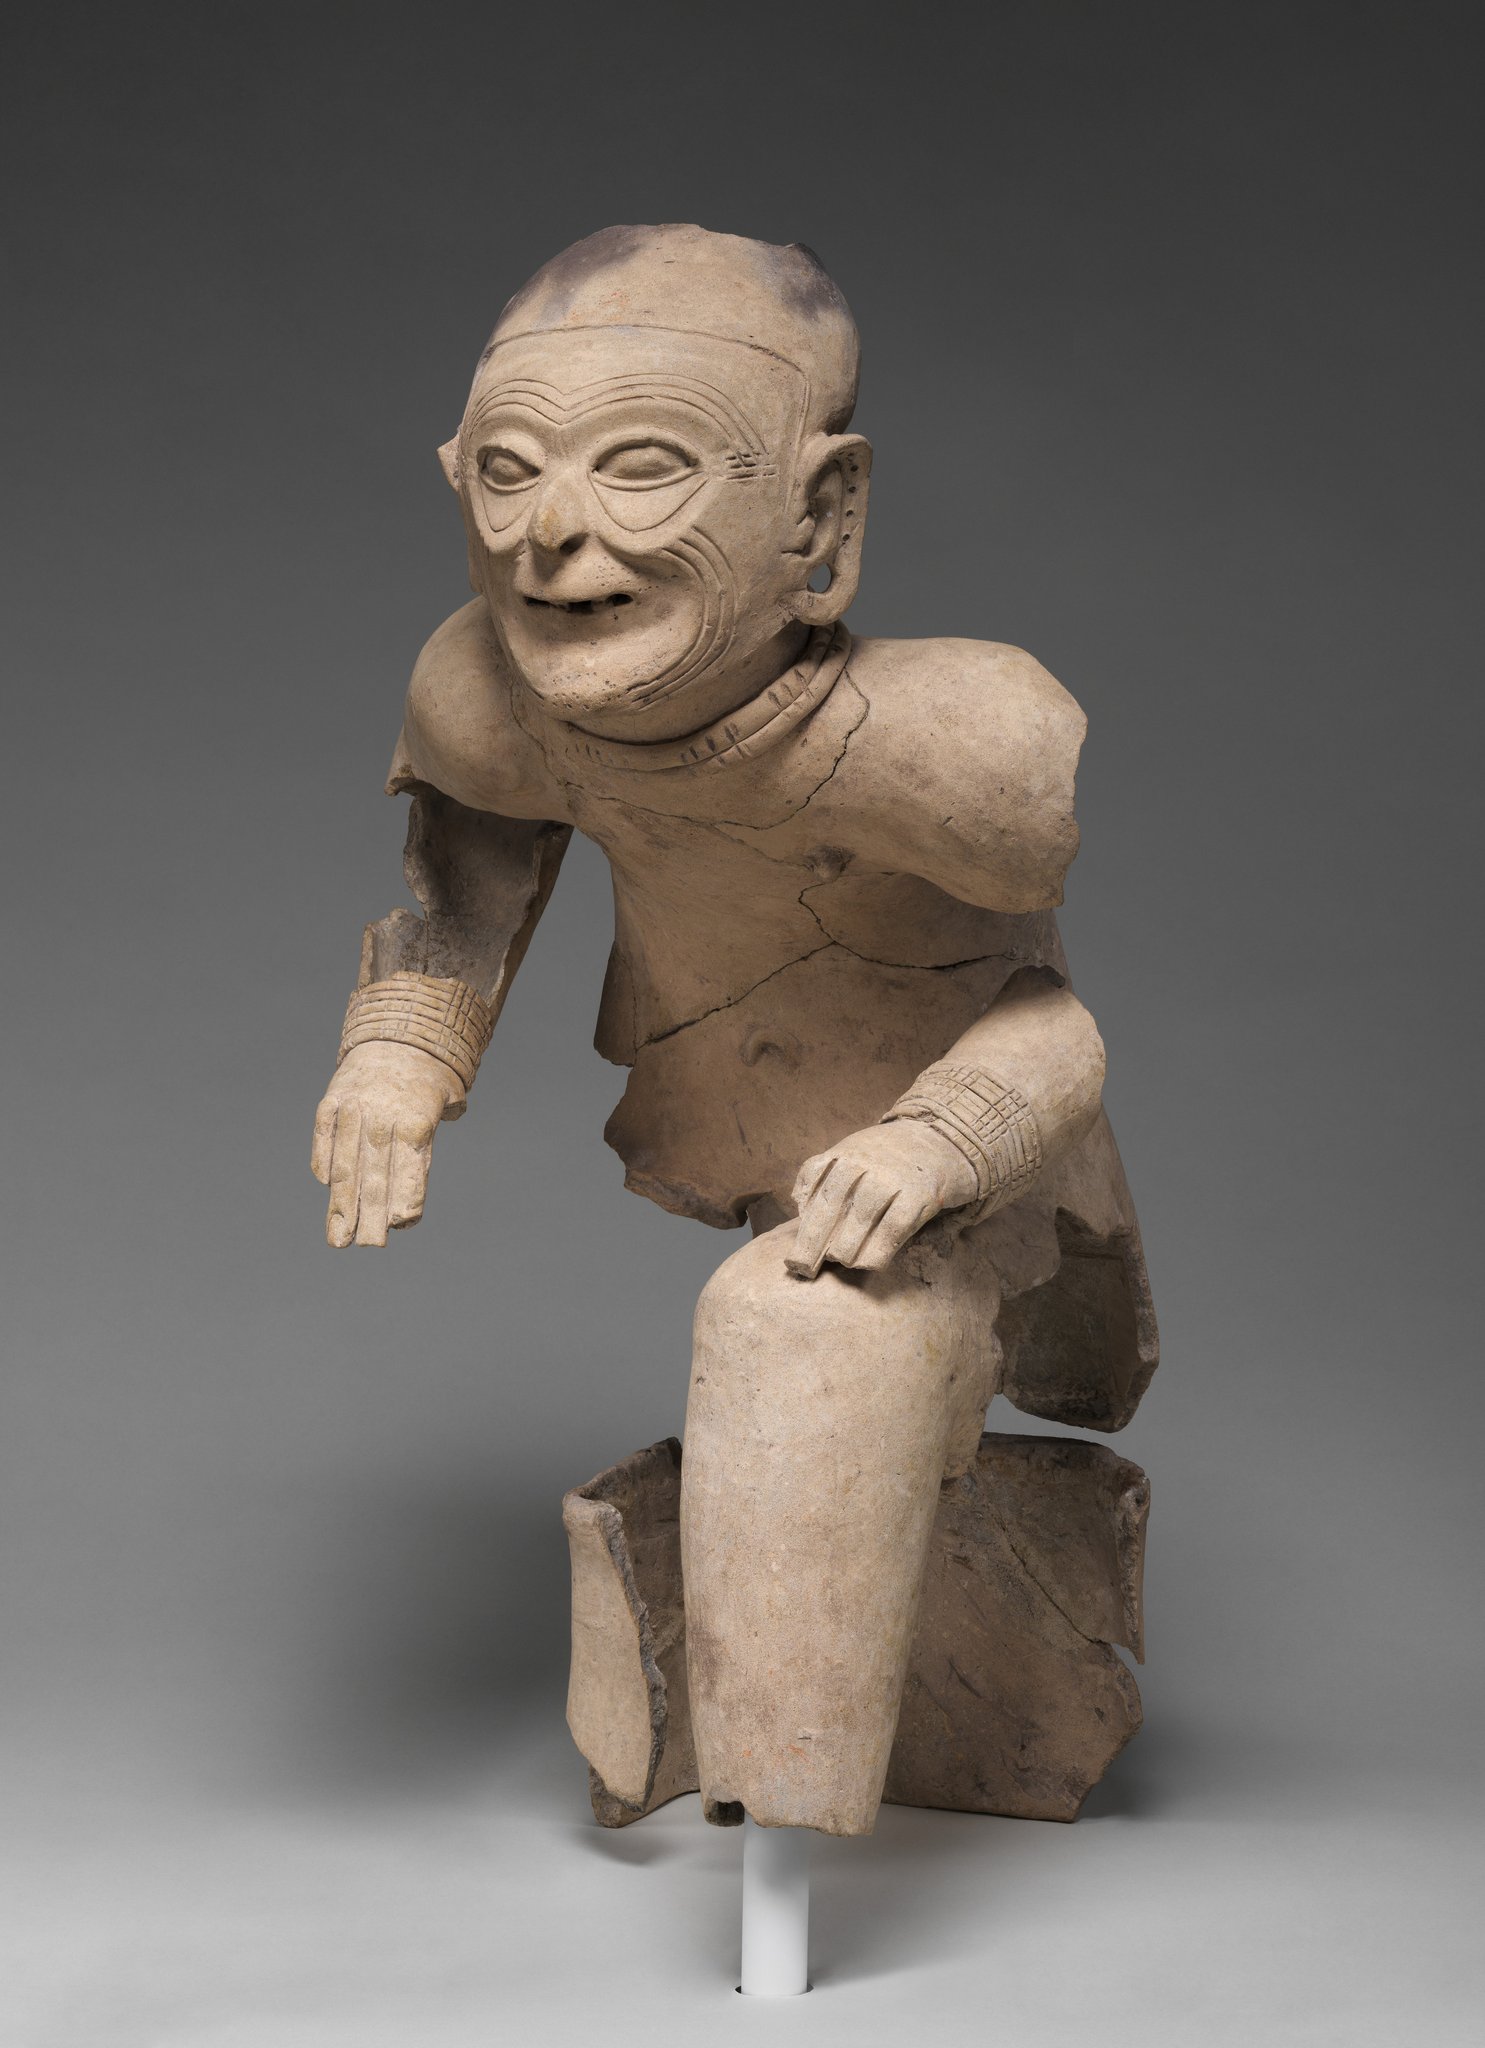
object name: figure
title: Seated elder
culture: tolita-tumaco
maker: tolita-tumaco artist(s)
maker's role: artist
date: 200 BCE-300 CE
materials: ceramic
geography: colombia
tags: men